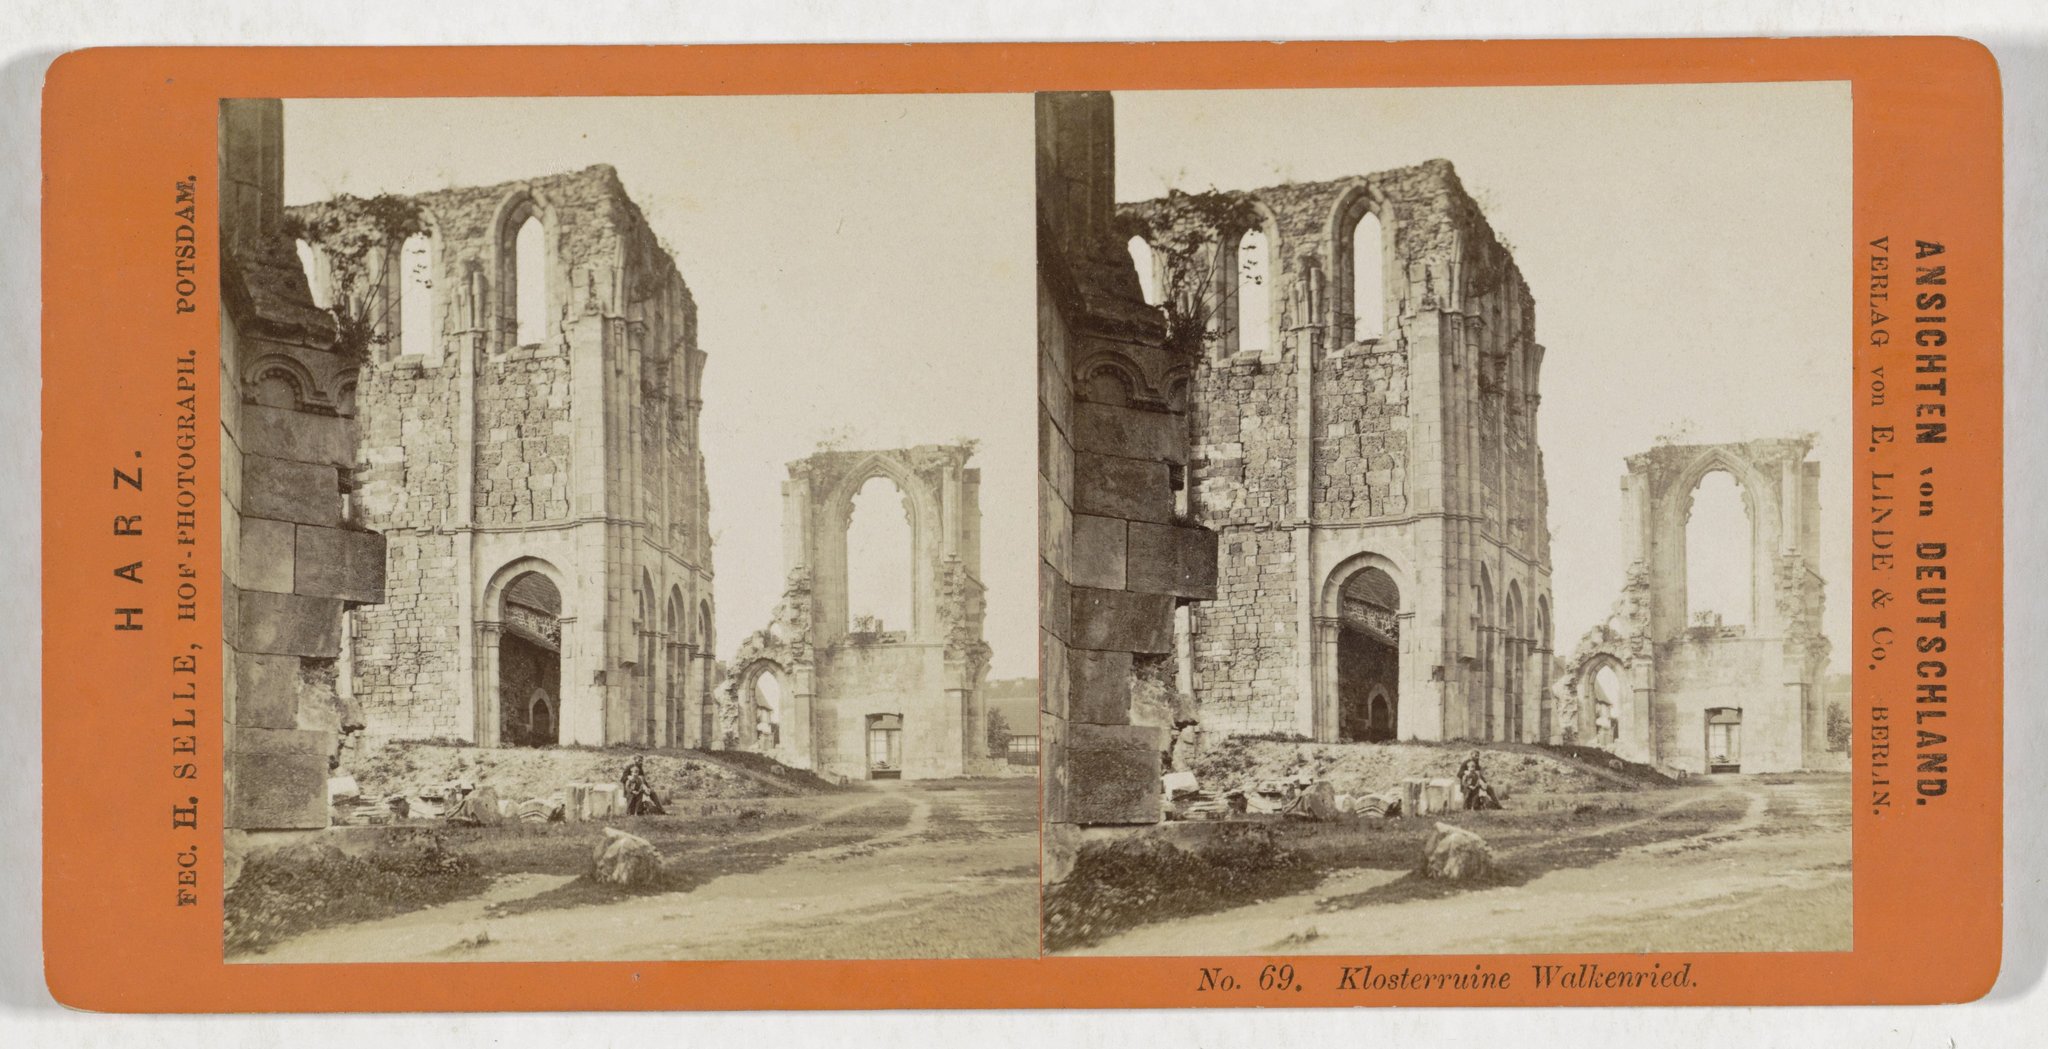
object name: stereograph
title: Ansichten von Deutschland / Harz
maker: hermann selle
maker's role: fotograaf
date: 1868-1890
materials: cardboard, paper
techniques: albumen print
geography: walkenried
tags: ruin of a building ~ architecture, ruin of church, monastery, etc.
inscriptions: inscription: ‘Hof-Photograph. Potsdam.’, number: ‘No. 69.’